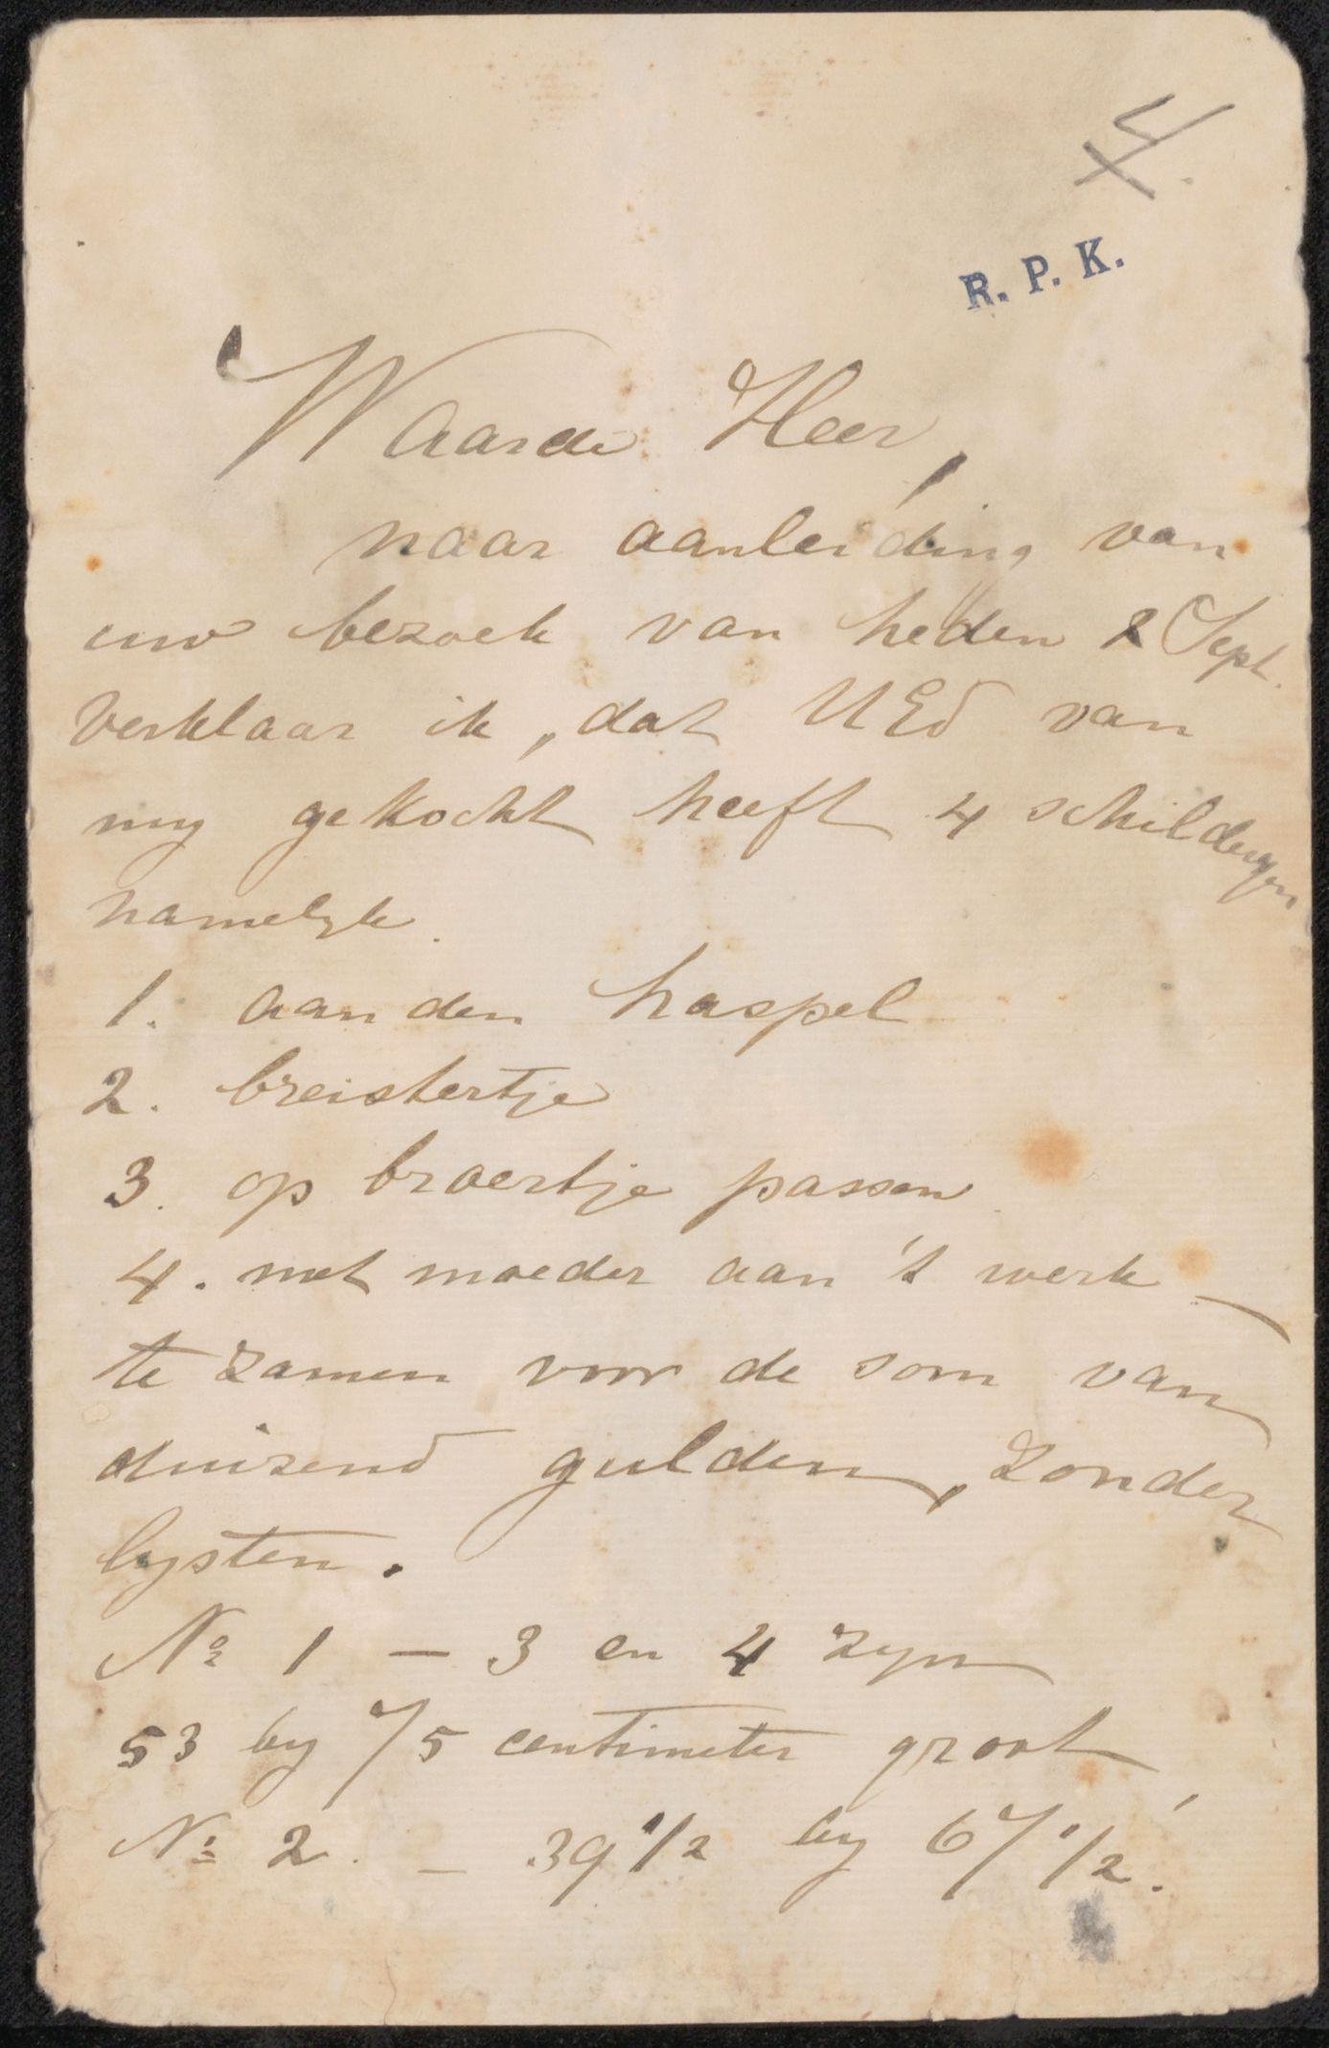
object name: letter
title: Brief aan Frans Buffa en Zonen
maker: wally moes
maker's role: draughtsman, print maker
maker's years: 1856-1918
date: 1886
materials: ink, paper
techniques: pen, writing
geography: laren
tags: publisher, utrecht, print maker, etha fles, art trade, art shop, drawing, painting (including book-illumination, miniature-painting), money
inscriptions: collector's mark: Lugt 2233